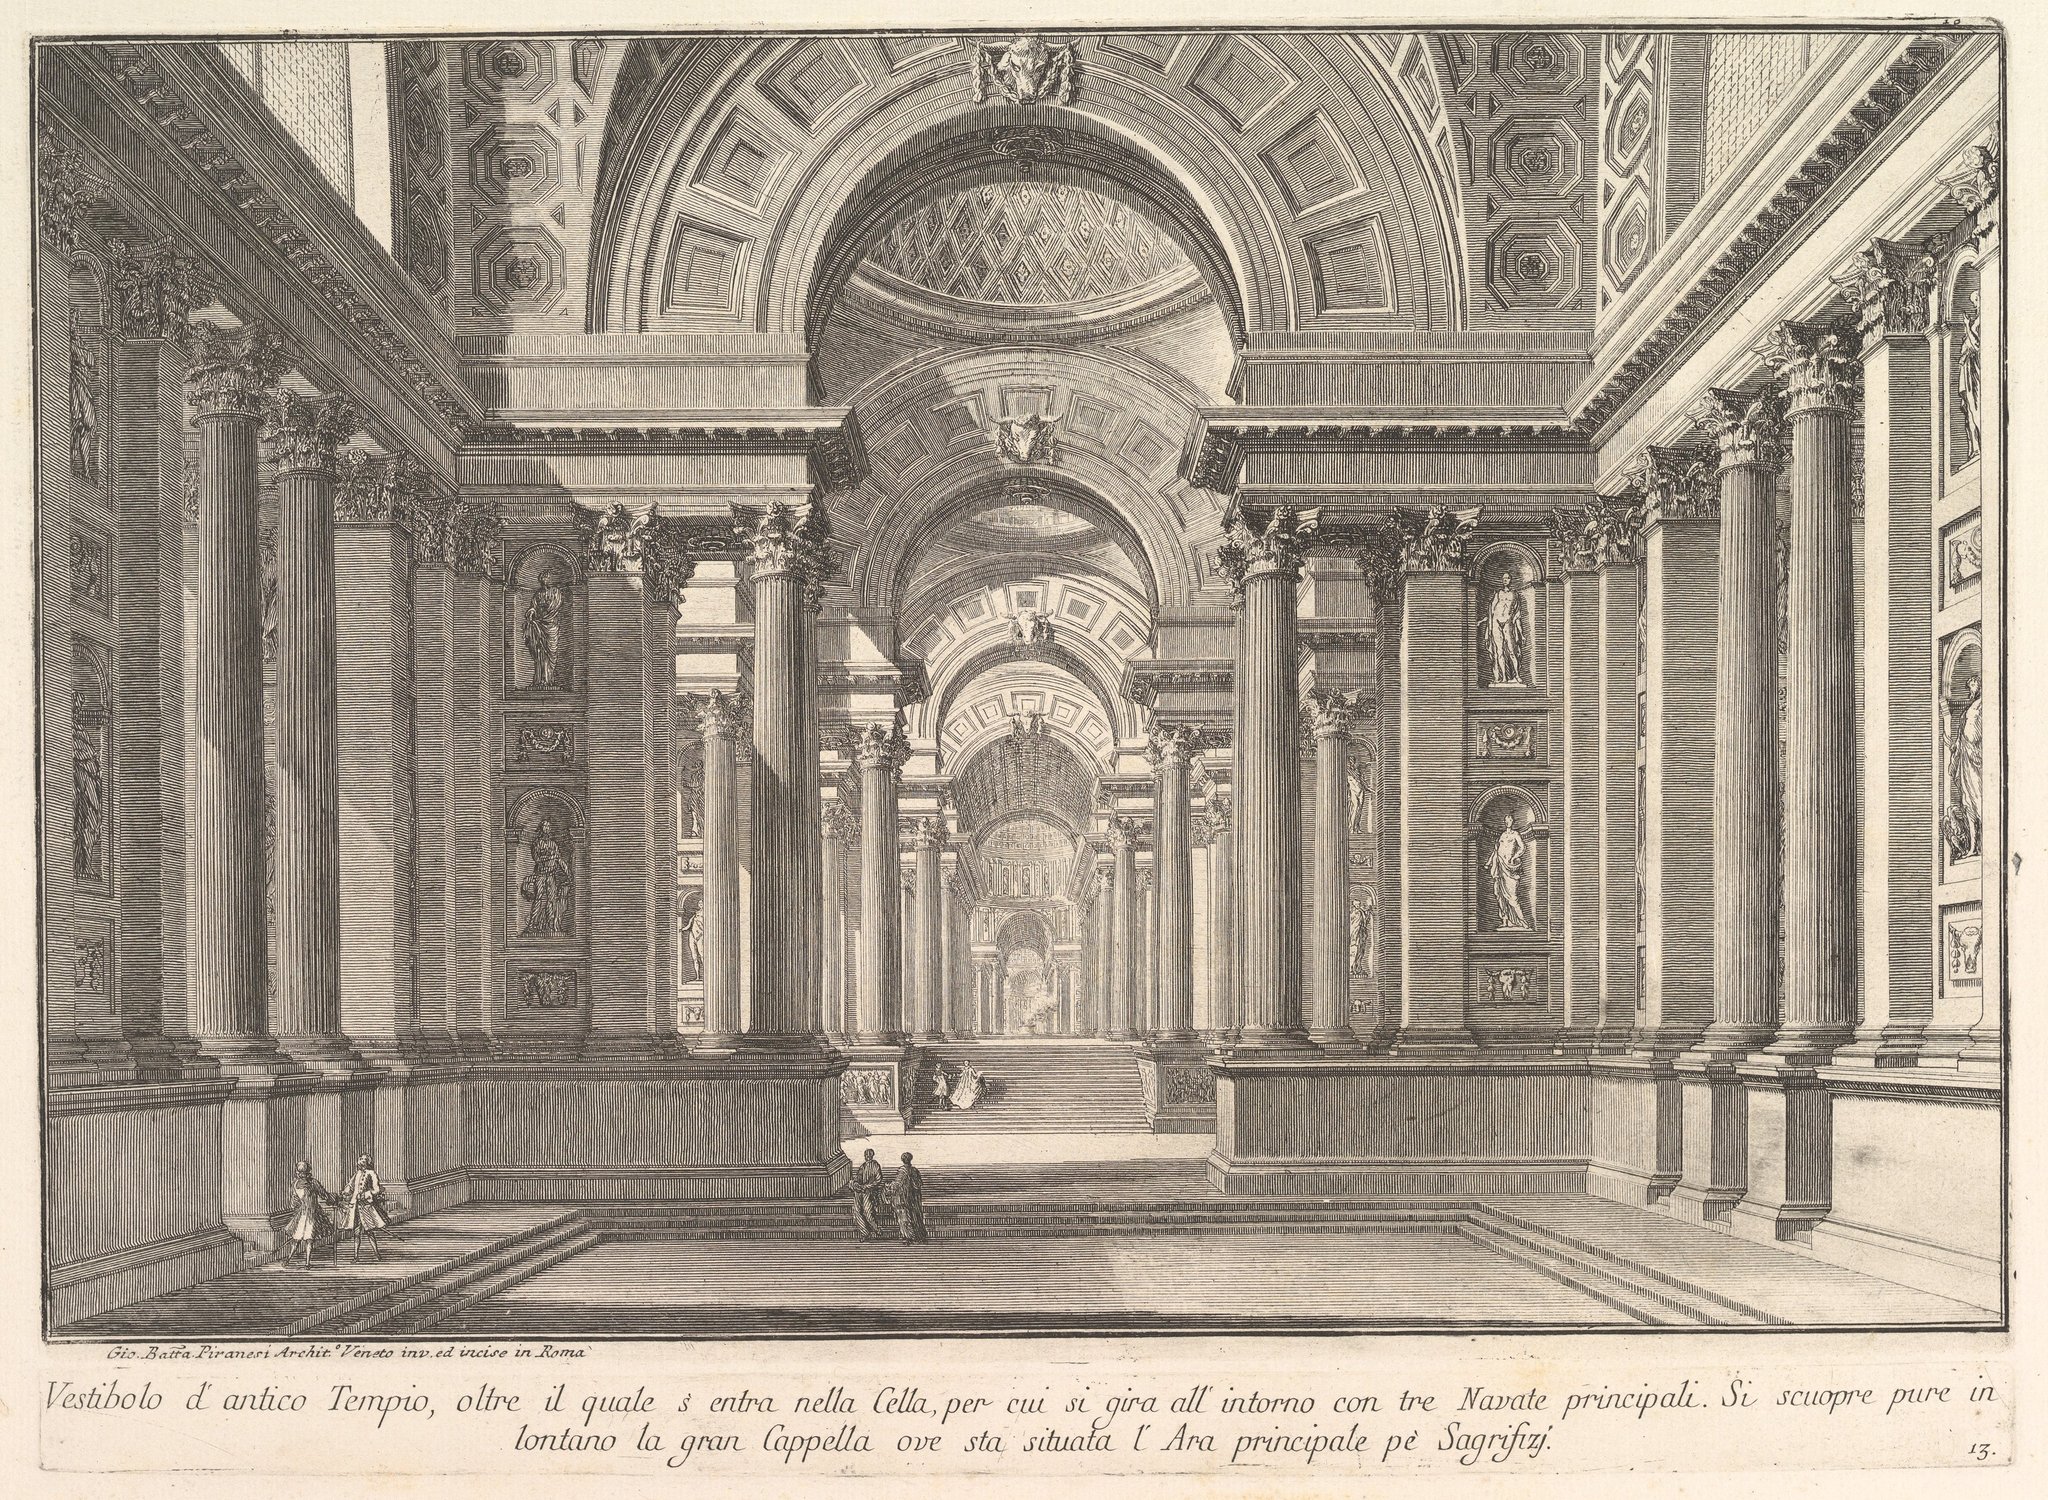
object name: print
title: Vestibule of an ancient temple... (Vestibolo d'antico Tempio...), from "Prima Parte di Architettura, e Prospettive"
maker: giovanni battista piranesi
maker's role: artist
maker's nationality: italian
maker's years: 1720-1778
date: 1743-1750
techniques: etching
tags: architecture,arches,temples